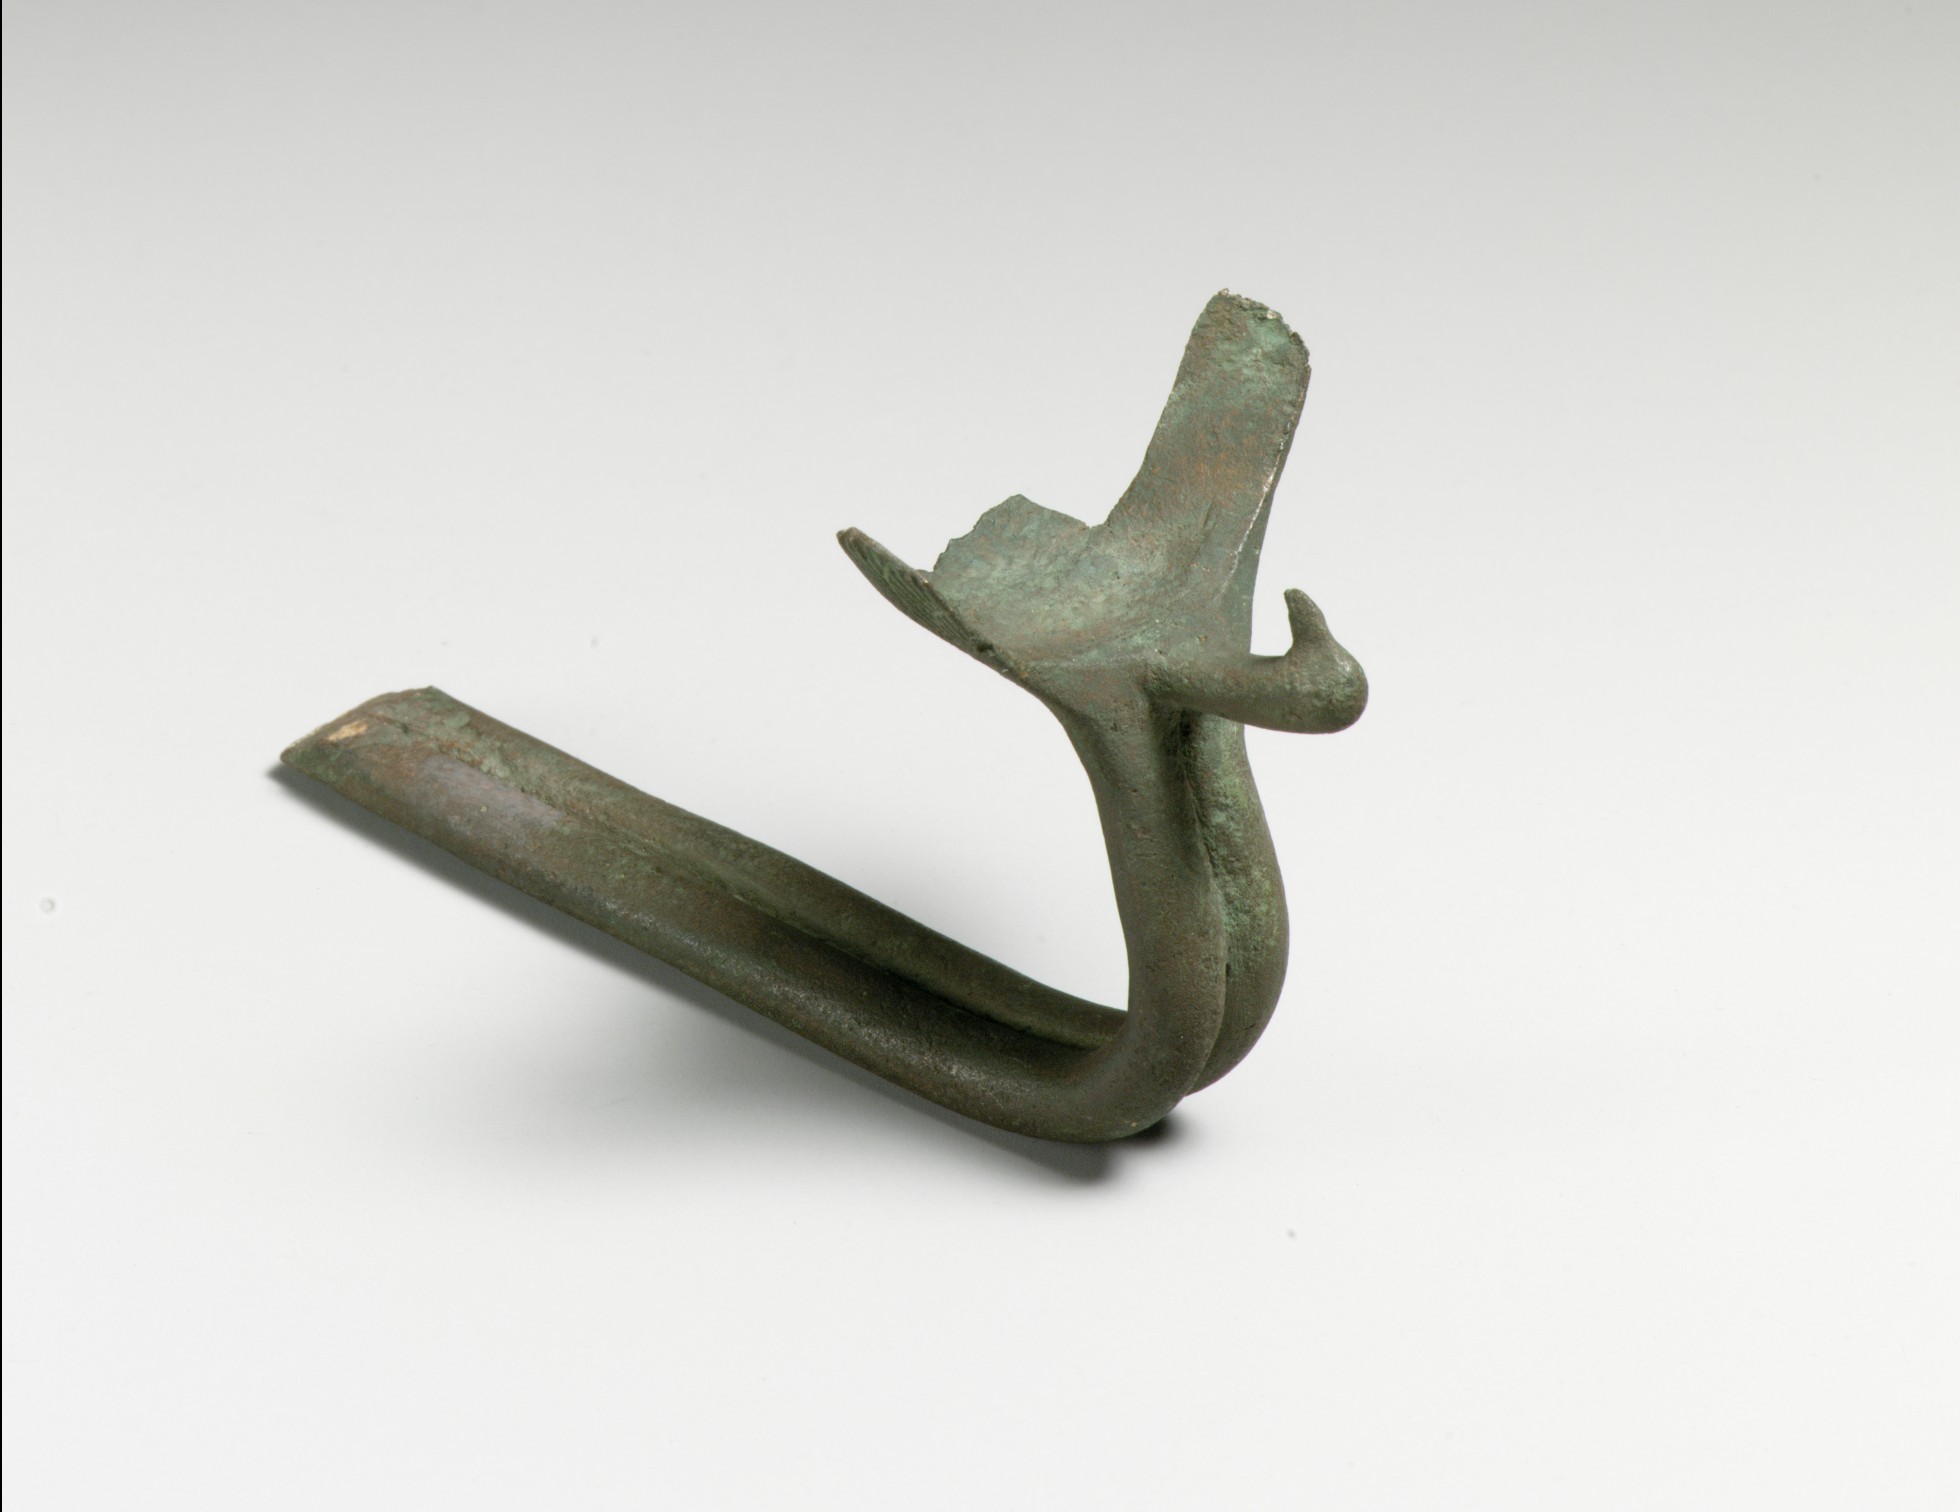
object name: handle of a jug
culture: cypriot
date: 700-501 BCE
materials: bronze